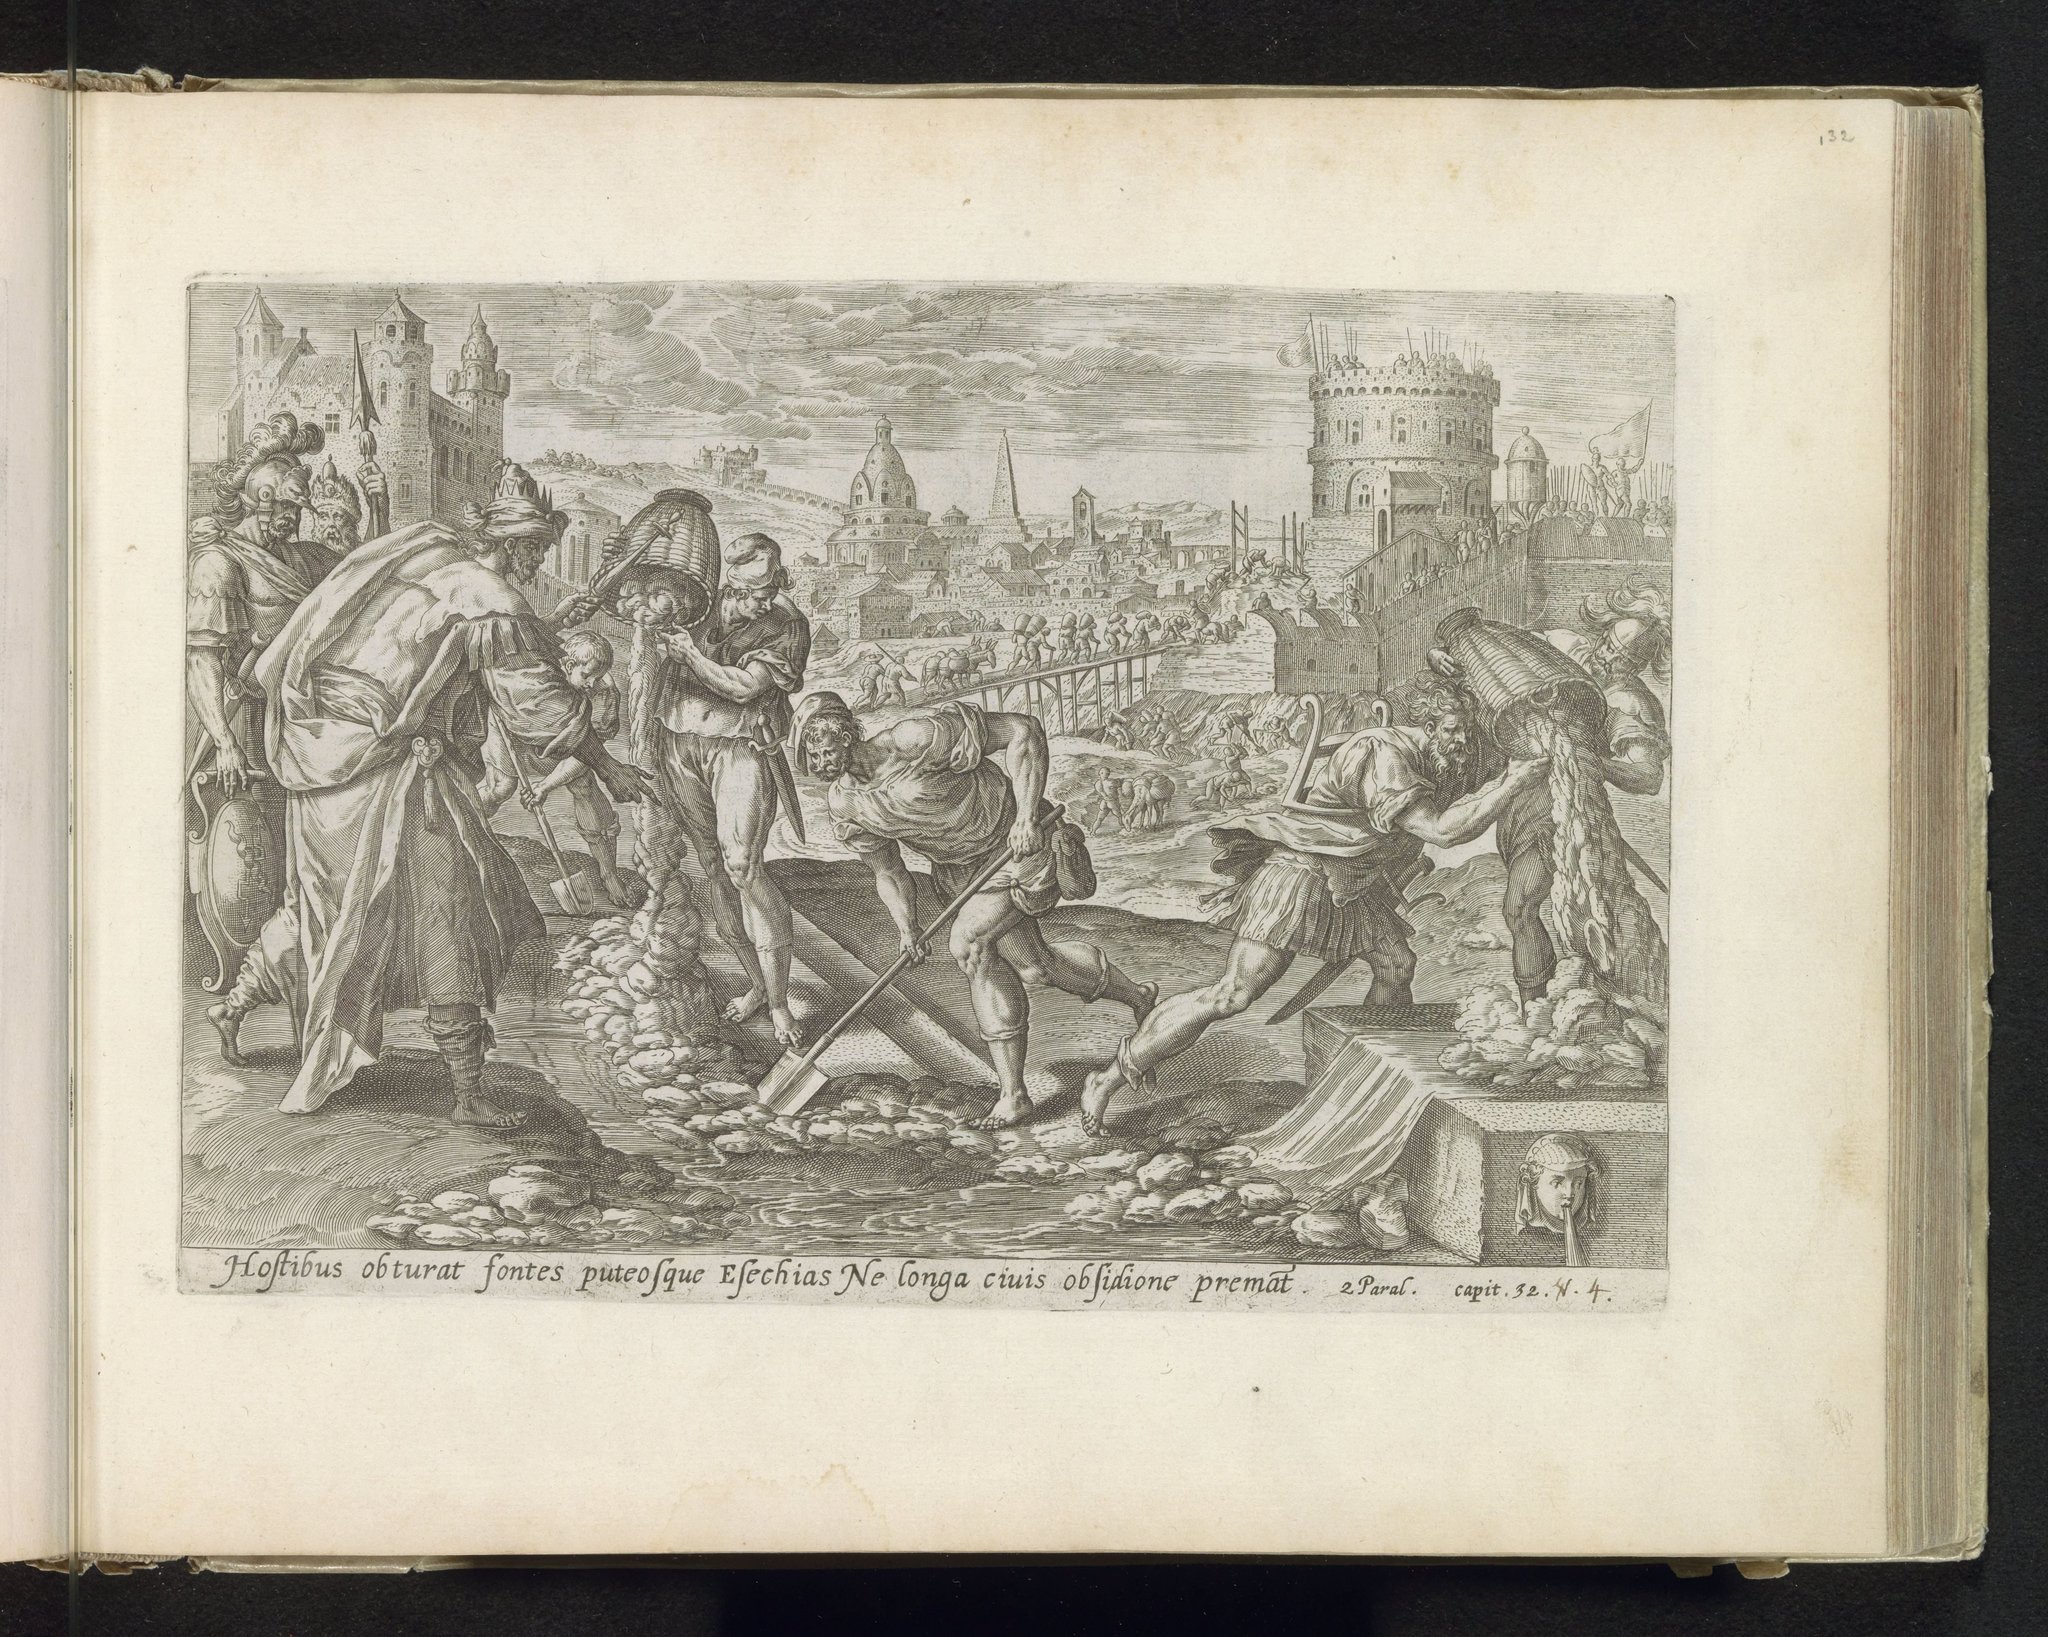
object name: print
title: Thesaurus sacrarum historiaru[m] veteris testame[n]ti, elega[n]tissimis imaginibus expressu[m] excelle[n]tissimoru[m] in hac arte viroru[m] opera: nu[n]c primu[m] in luce[m] editus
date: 1585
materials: paper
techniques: engraving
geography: antwerp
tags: jerusalem's walls are repaired and towers built on it, hezekiah, for the defense of jerusalem, cuts off the supply of water outside the city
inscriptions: inscription: ‘V. 4.’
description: Koning Hizkia laat de bronnen en irrigatiekanalen buiten Jeruzalem afsluiten, zodat Sanherib en zijn leger bij de belegering van Jeruzalem geen overvloed aan water zullen hebben. Op de achtergrond worden de muren van Jeruzalem verstevigd en van torens voorzien. Onder de voorstelling een verwijzing in het Latijn naar de Bijbeltekst in 2 Kron. 32. Deze prent maakt deel uit van een album.